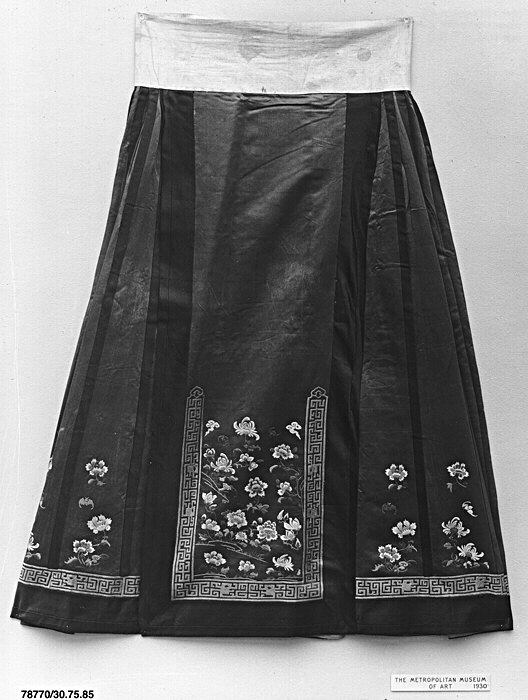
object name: skirt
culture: chinese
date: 1701-1900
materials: silk